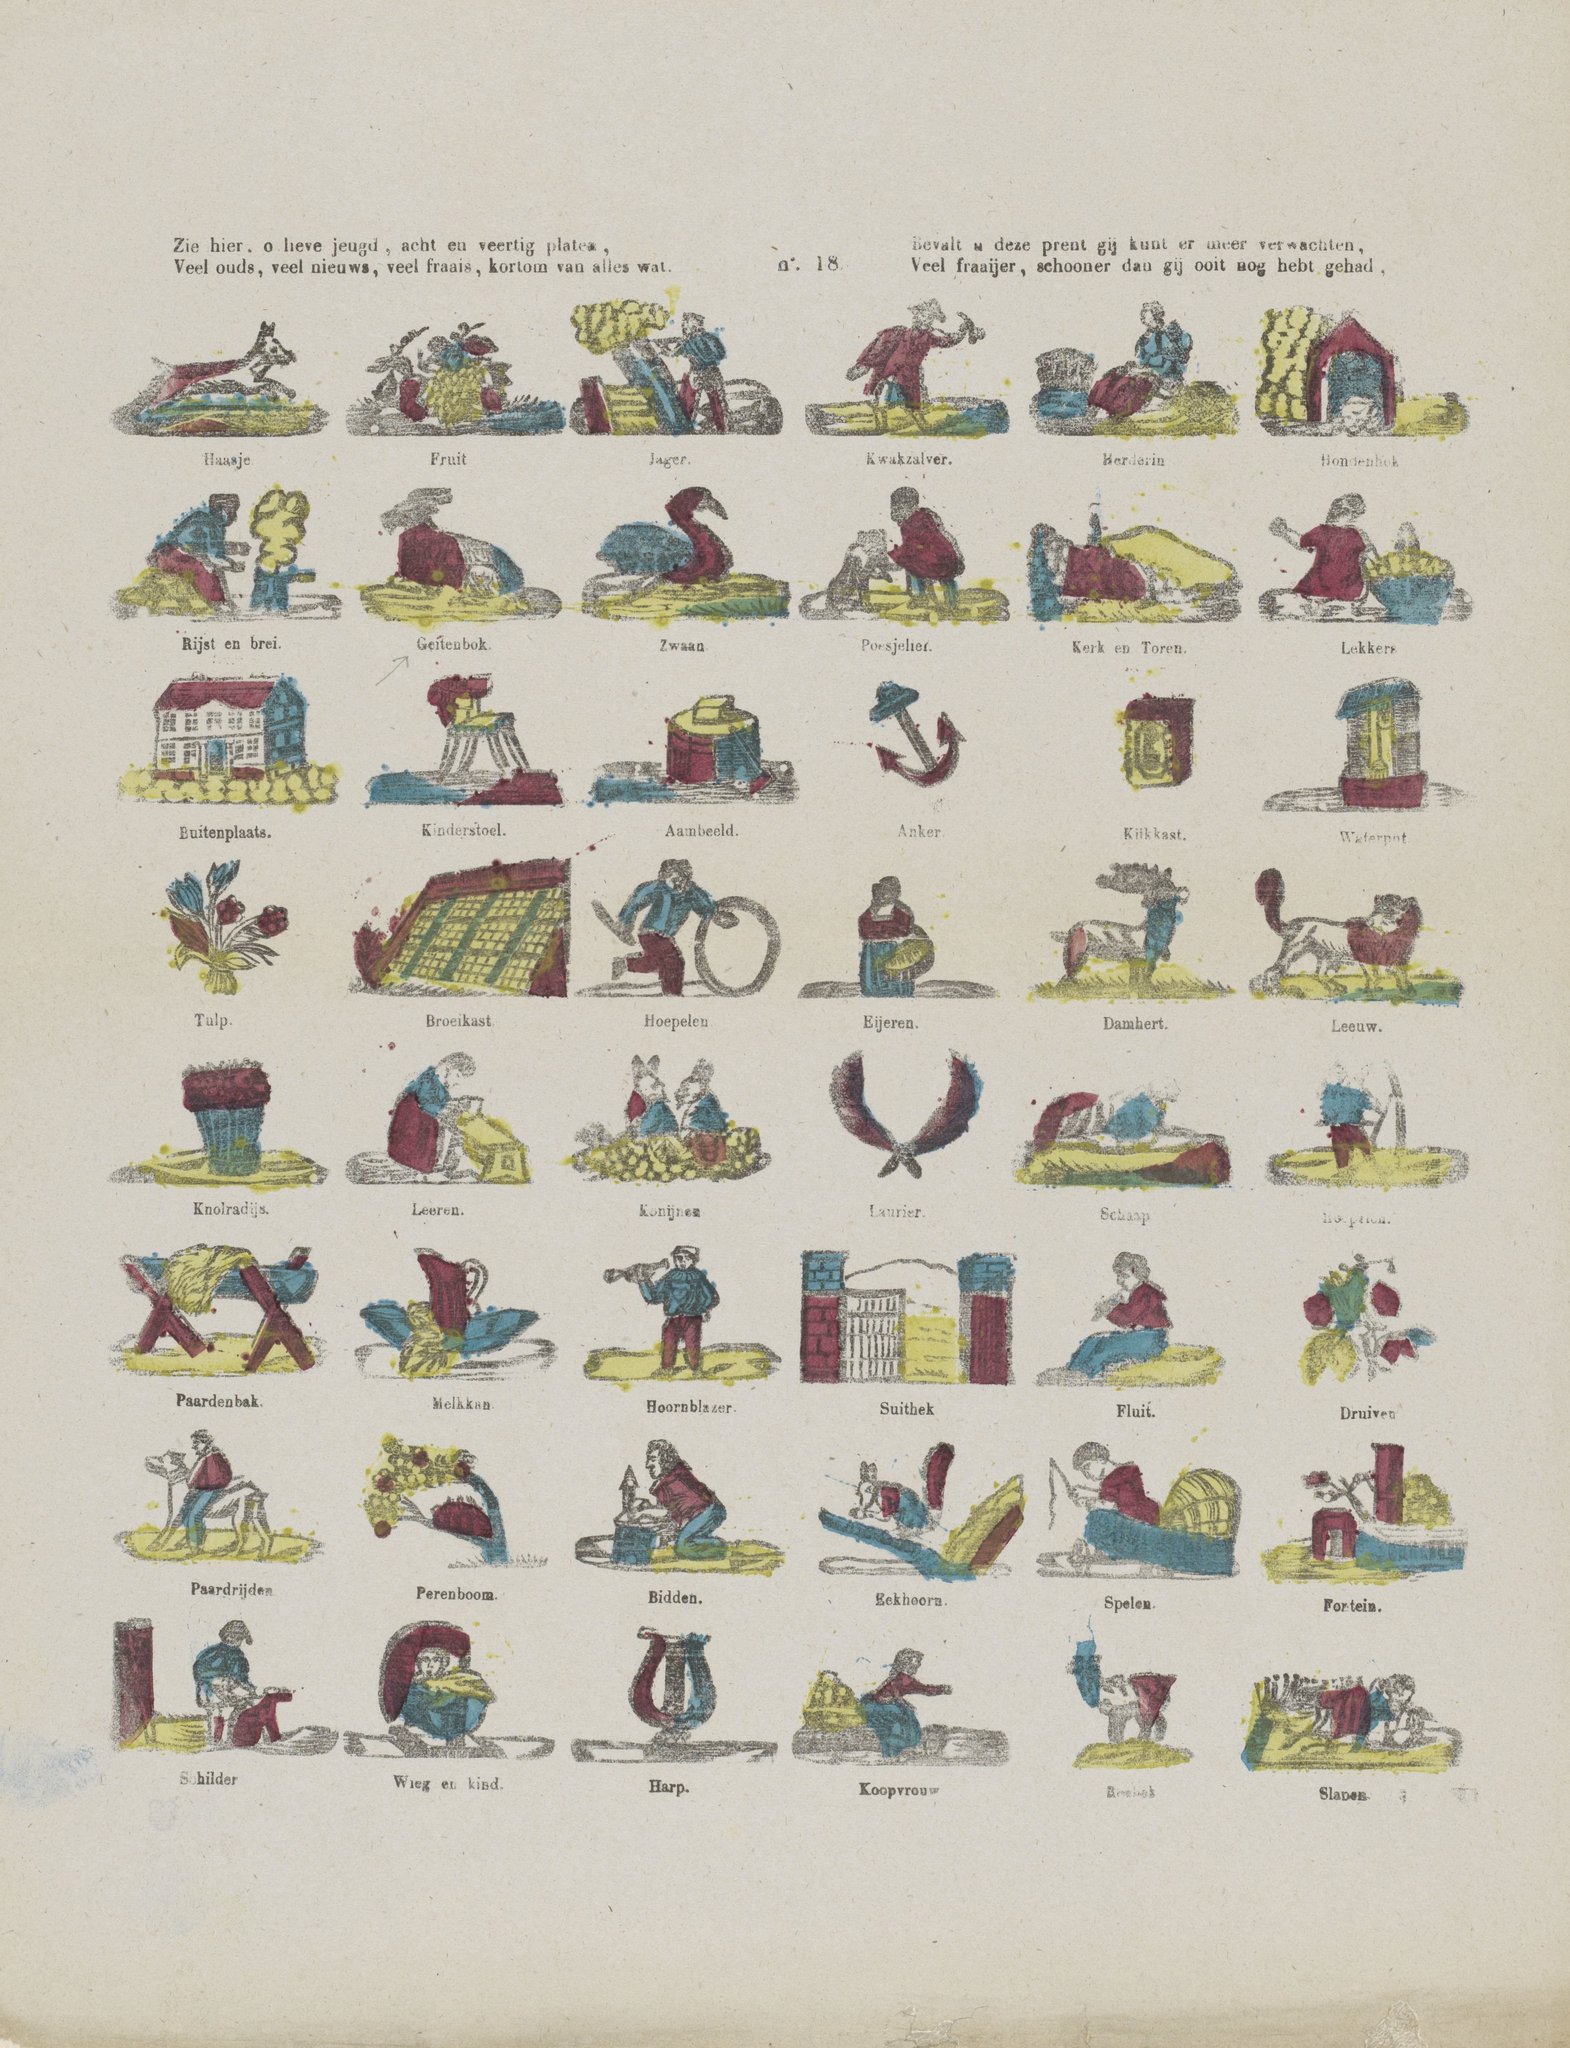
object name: print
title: Zie hier, o lieve jeugd, acht en veertig platen, / Veel ouds, veel nieuws, veel fraais, kortom van alles wat. / Bevalt u deze prent gij kunt er meer verwachten, / Veel fraaijer, schooner dan gij ooit nog hebt gehad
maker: Anonymous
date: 1848-1881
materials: paper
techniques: colour, letterpress printing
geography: den bosch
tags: animals, human types, characters (human types)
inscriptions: collector's mark: Lugt 2760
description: Blad met 48 voorstellingen van verschillende voorwerpen, dieren en figuren. Onder elke afbeelding een onderschrift. Genummerd midden boven: no. 18.